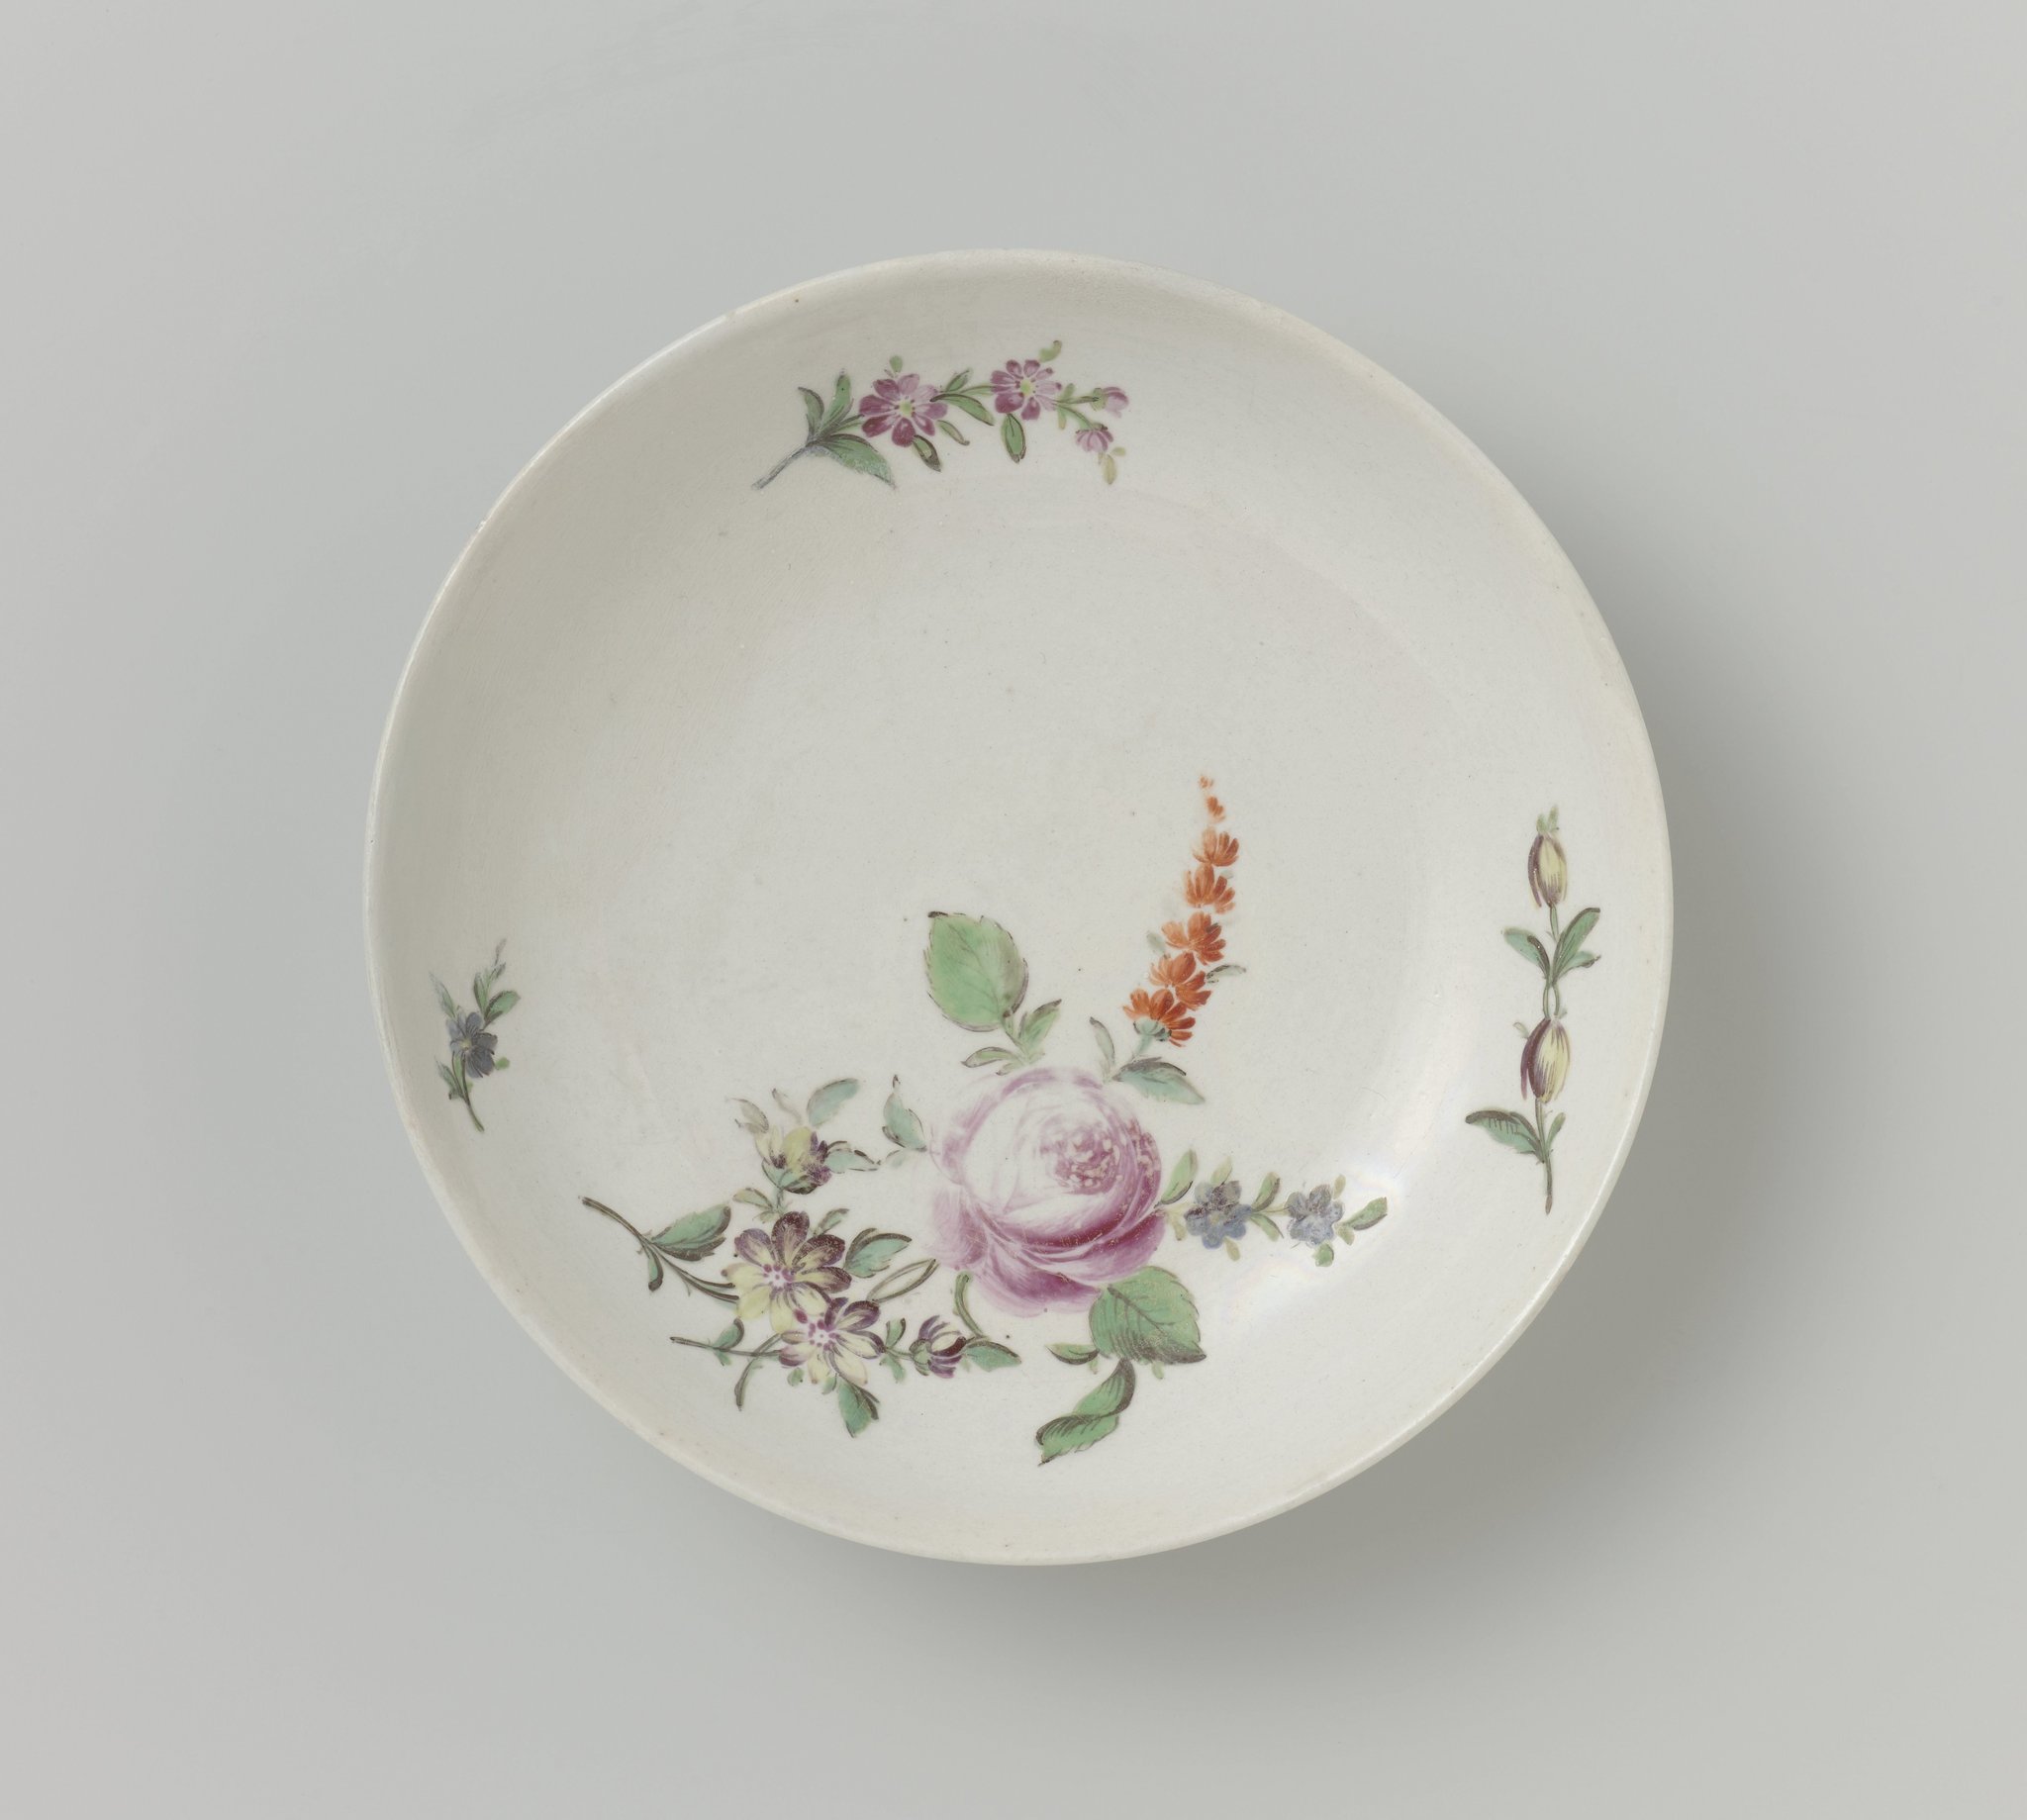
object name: platter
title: Schotel, veelkleurig beschilderd met bloemboeket en strooibloemen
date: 1759-1771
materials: porcelain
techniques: painted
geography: weesp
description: Schotel, veelkleurig beschilderd met een bloemboeket en strooibloemen. Gemerkt met twee gekruiste zwaarden en drie bollen in onderglazuurblauw.